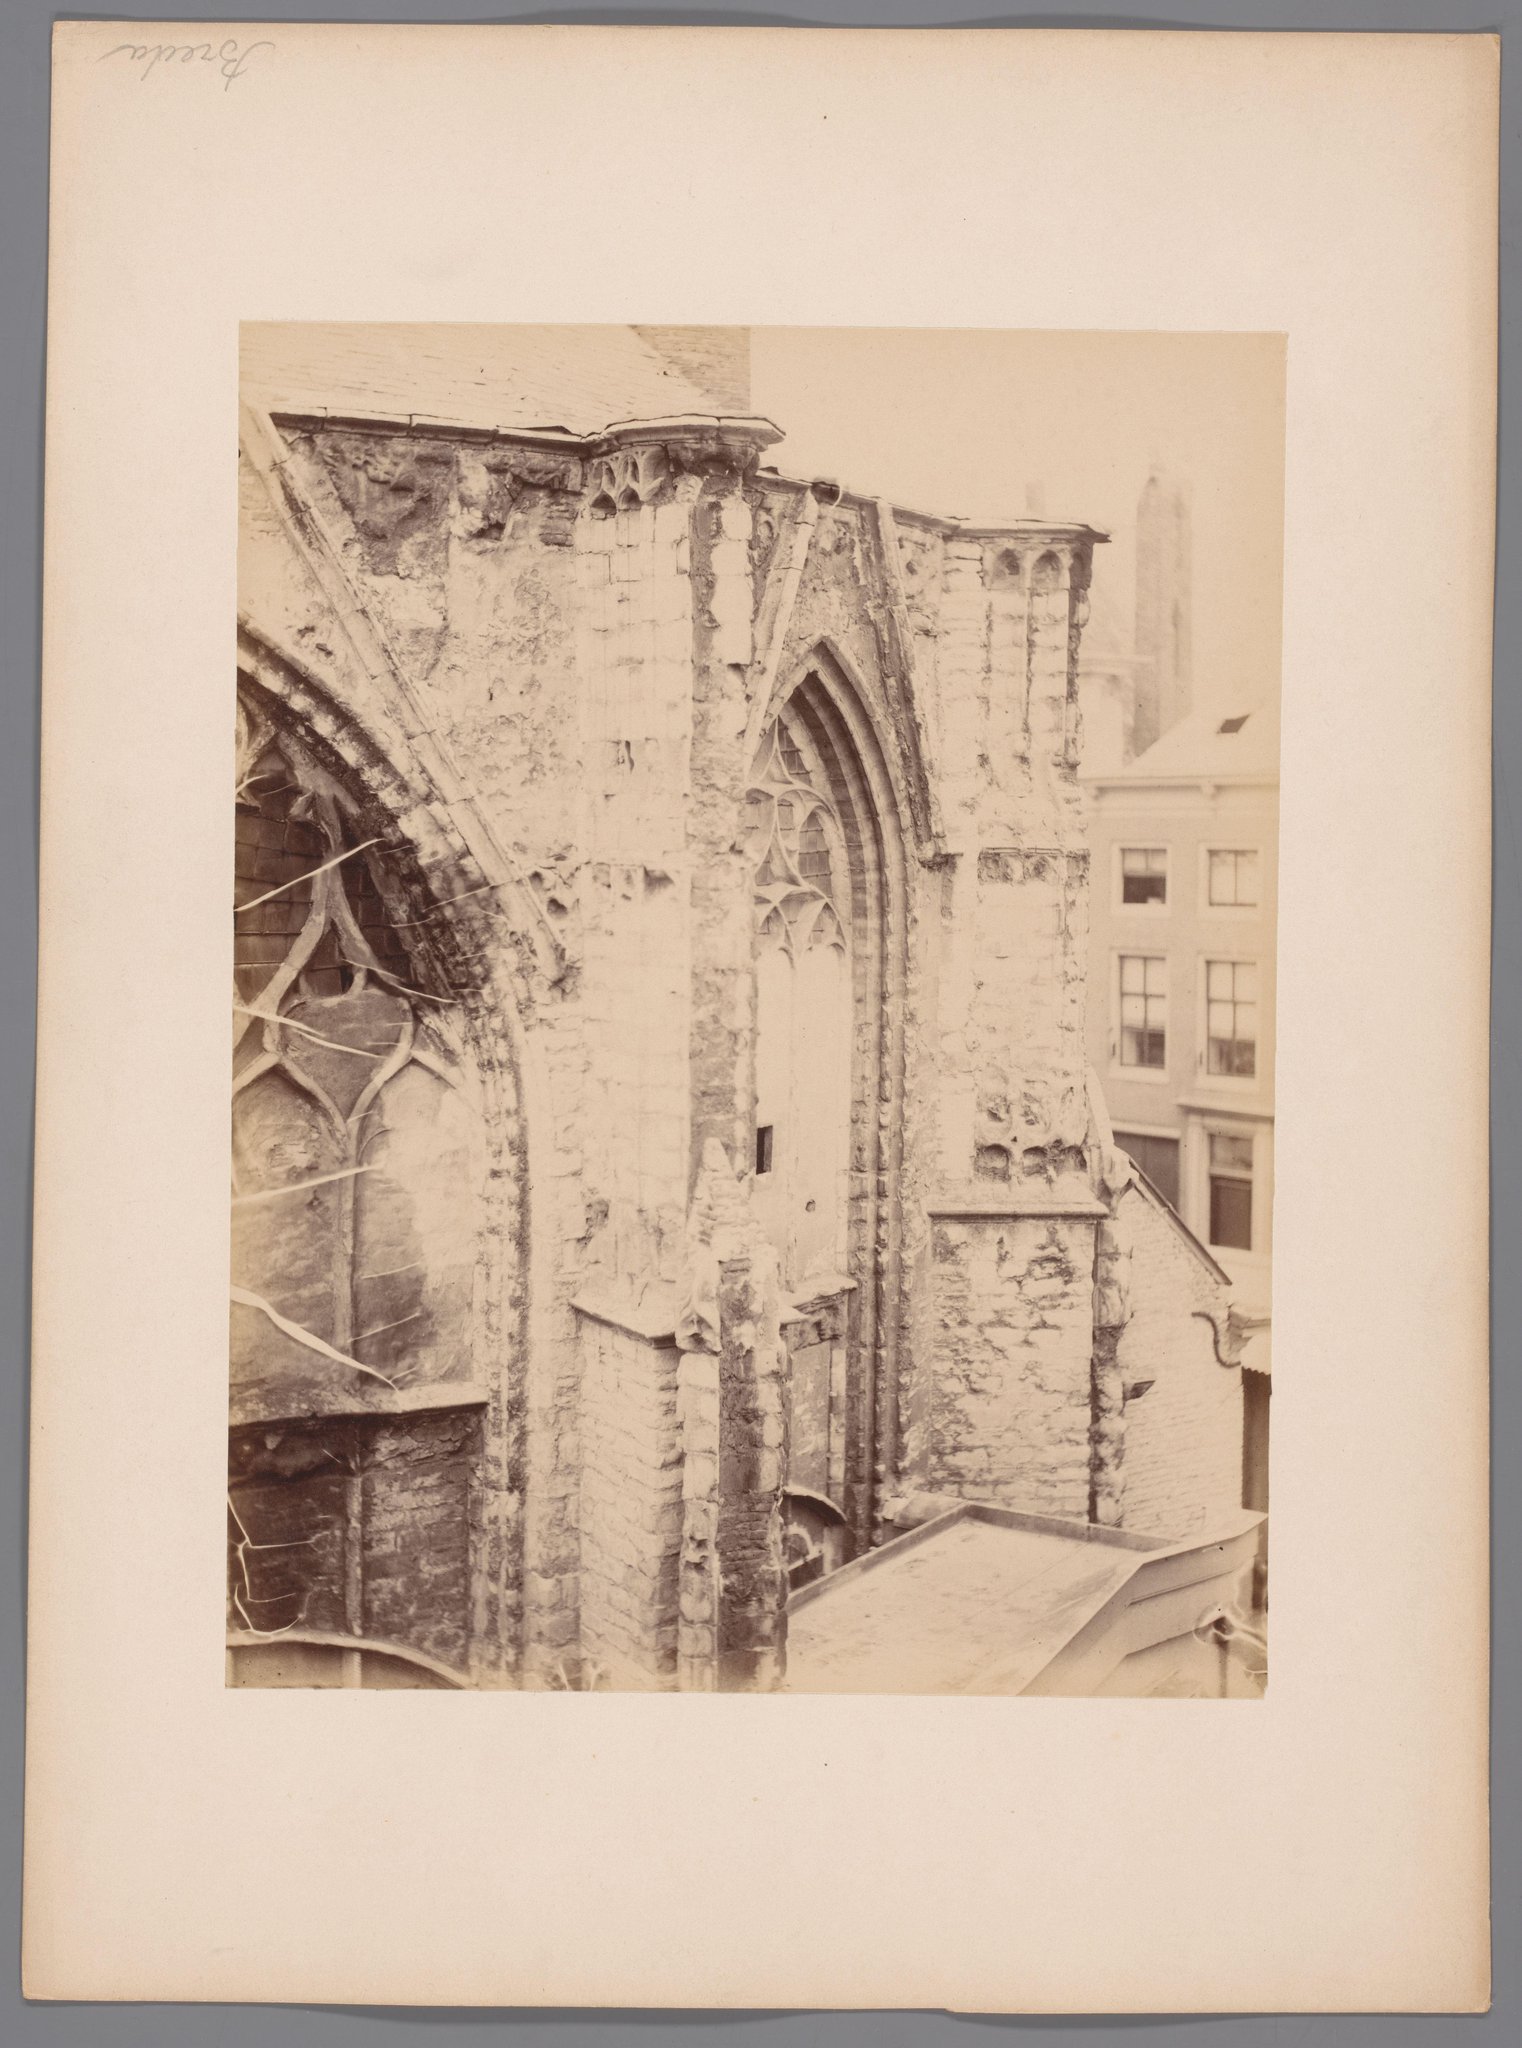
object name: photograph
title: Zuidzijde van de Grote Kerk te Breda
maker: anoniem (monumentenzorg)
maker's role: fotograaf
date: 1890-1920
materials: cardboard, photographic support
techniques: albumen print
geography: breda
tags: parts of church exterior and annexes: transept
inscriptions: annotation: ‘N.H. Kerk te Breda/ Zuidzijde rechts van transept en de consistoriekamer’, annotation: ‘Breda’